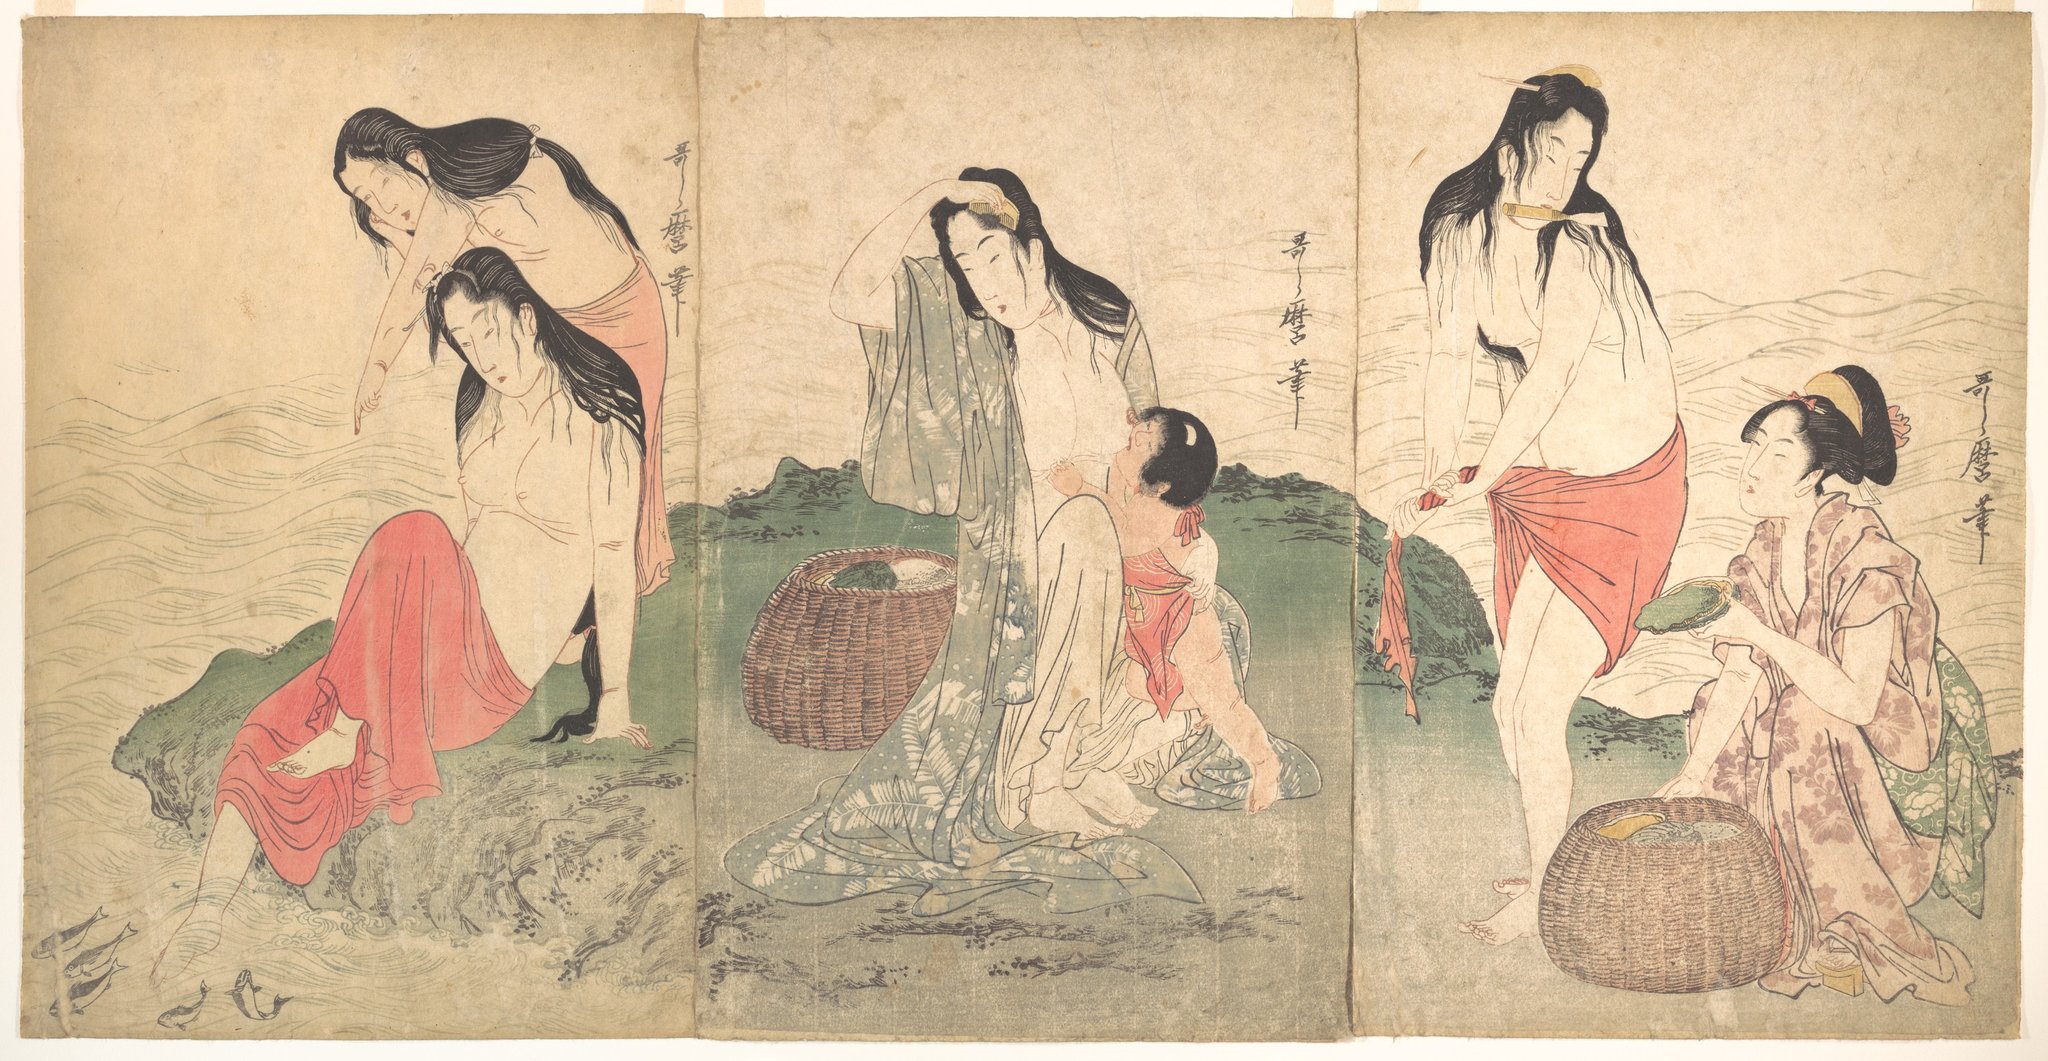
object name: woodblock print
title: The Awabi Fishers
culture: japanese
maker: kitagawa utamaro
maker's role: artist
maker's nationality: japanese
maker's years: 1754-1806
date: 1754-1806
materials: ink, paper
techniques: woodblock print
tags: children,female nudes,fishing